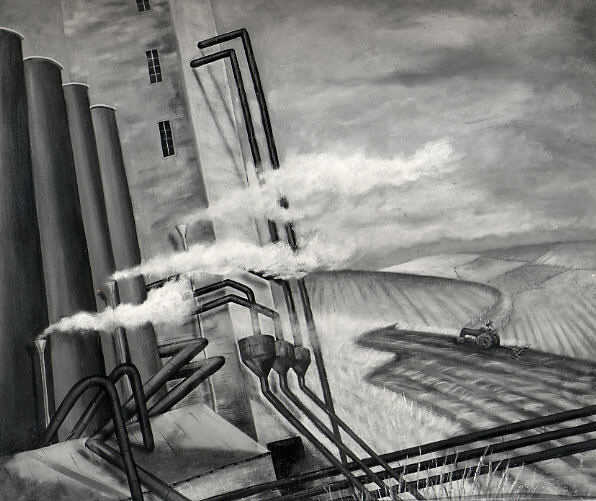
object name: painting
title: National Defense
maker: william tasker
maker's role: artist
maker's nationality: american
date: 1900-1943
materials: canvas, oil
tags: factories,farms